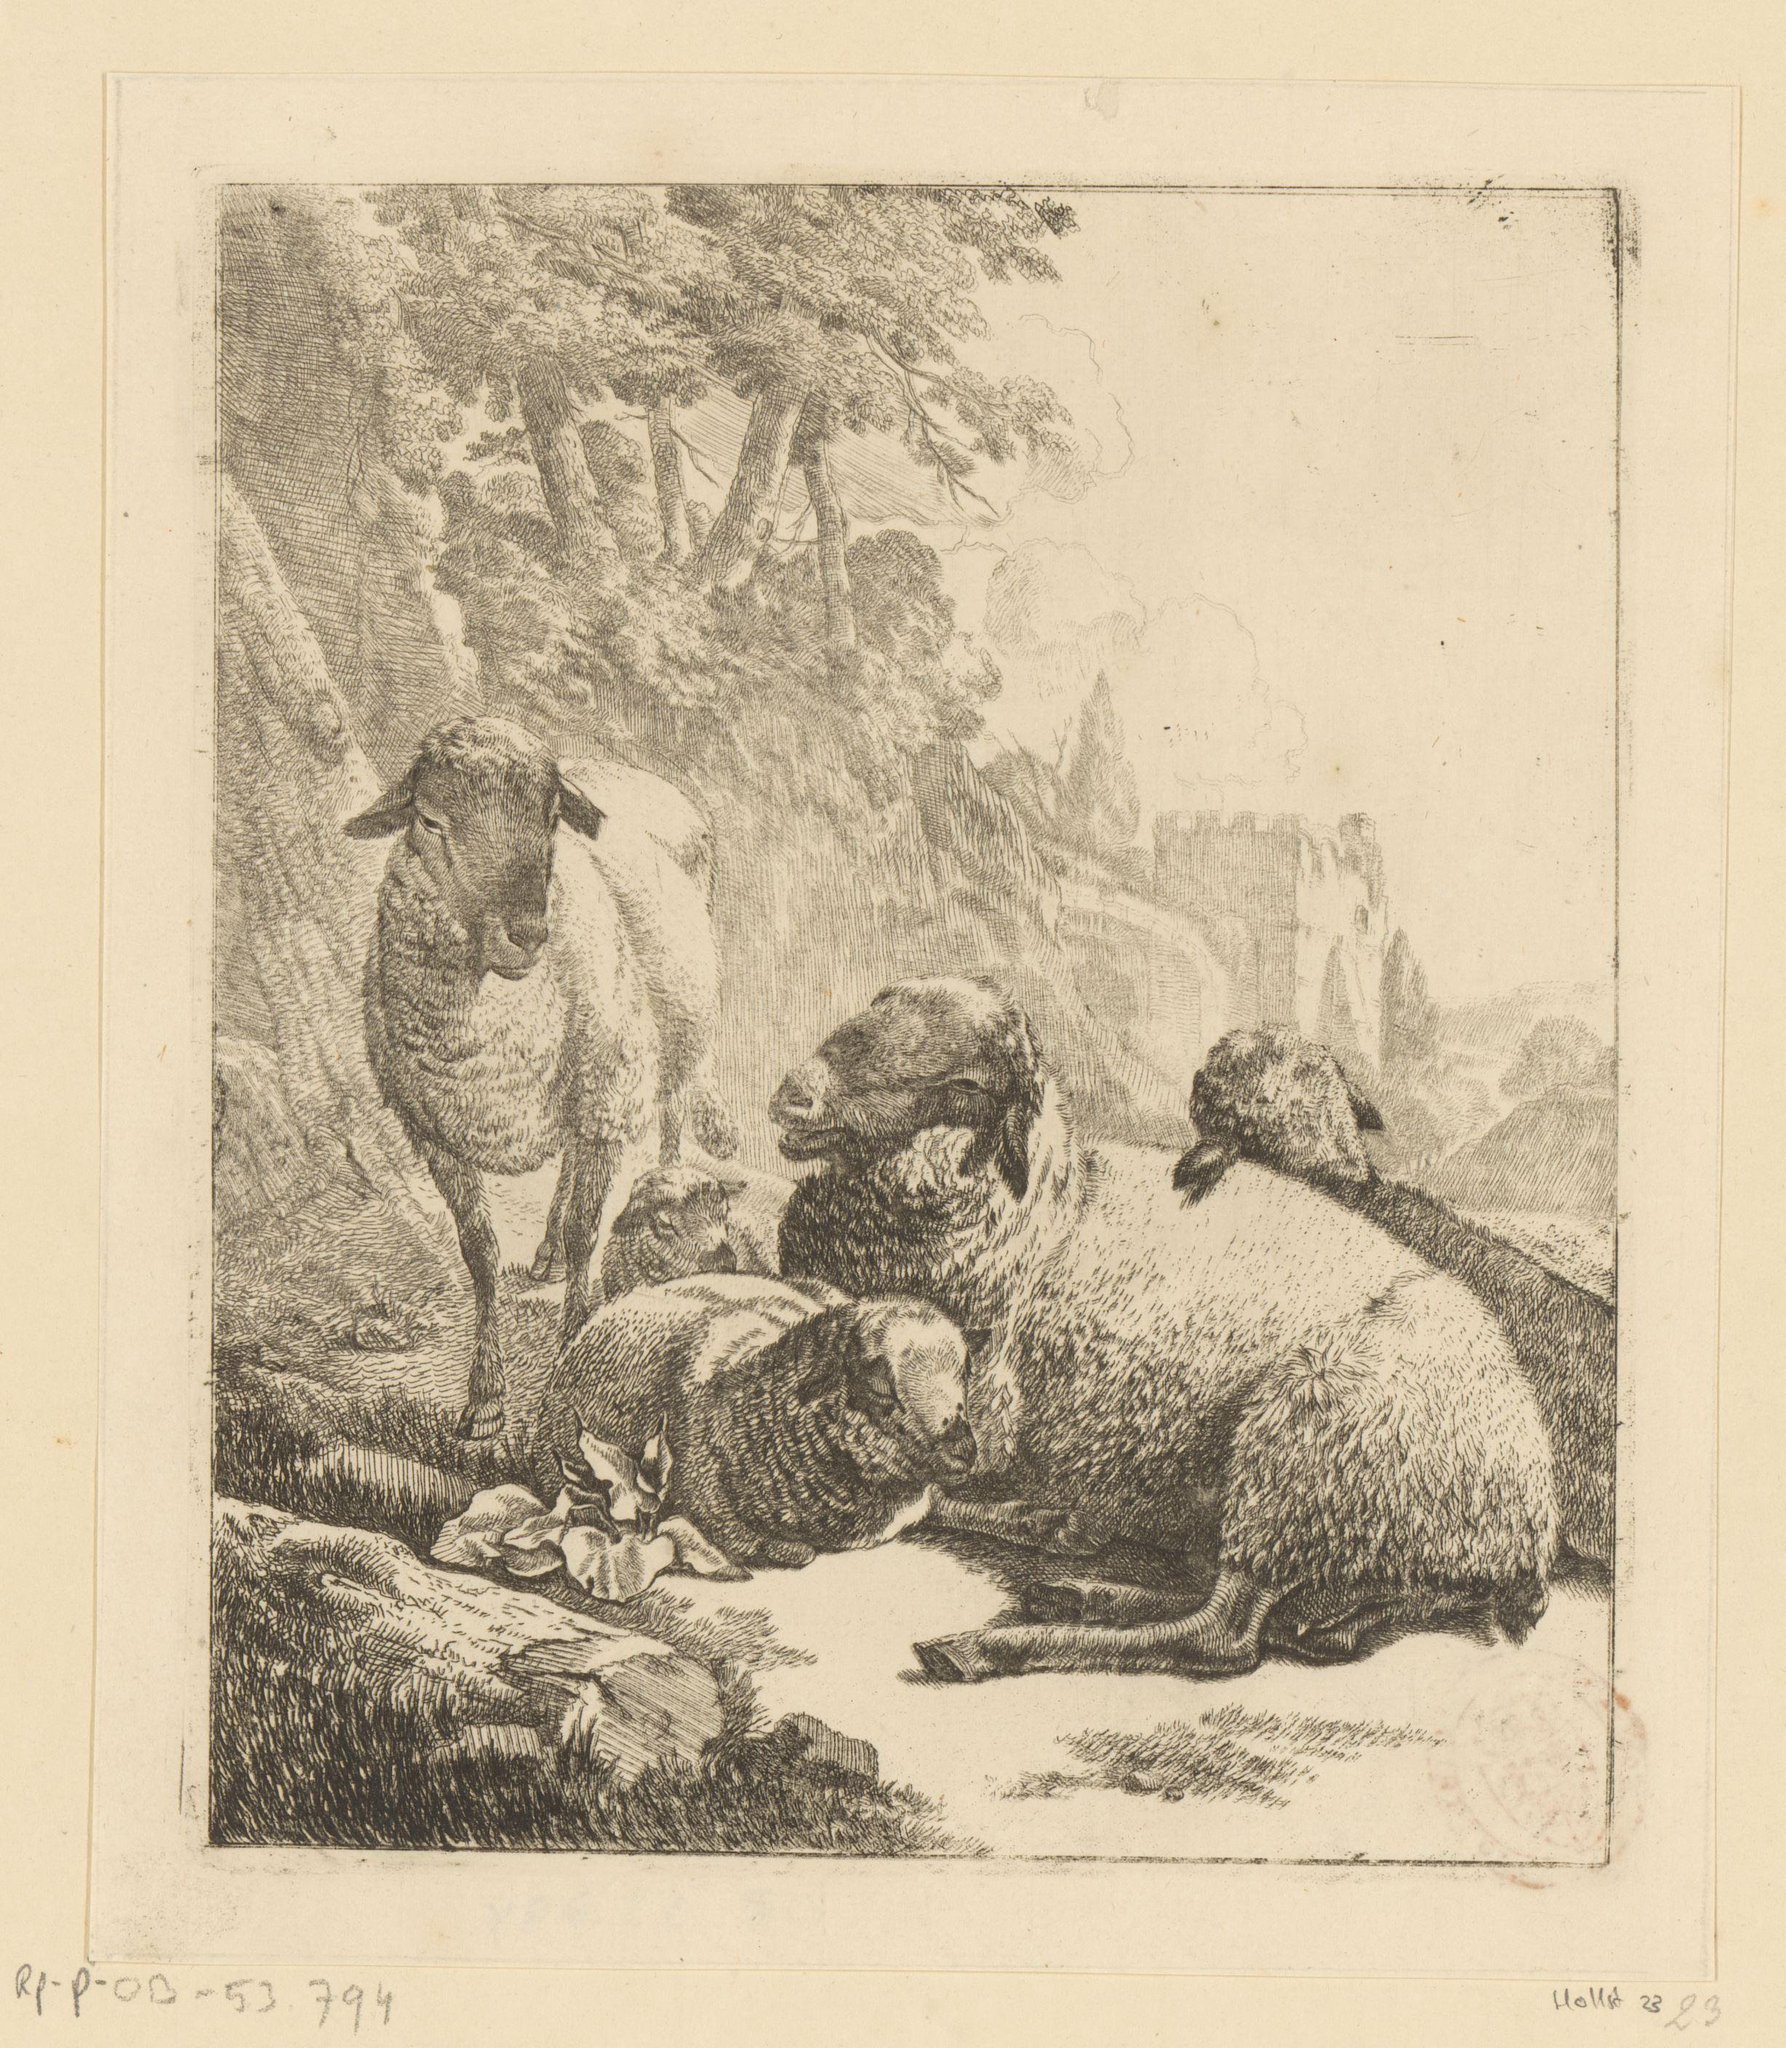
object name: print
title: Staand schaap en vier liggende schapen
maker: johann heinrich roos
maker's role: draughtsman, print maker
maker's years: 1631-1685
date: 1668-1670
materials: paper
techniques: etching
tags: landscapes, sheep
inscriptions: collector's mark: Lugt 240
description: Serie van twaalf prenten, waarvan één titelprent.